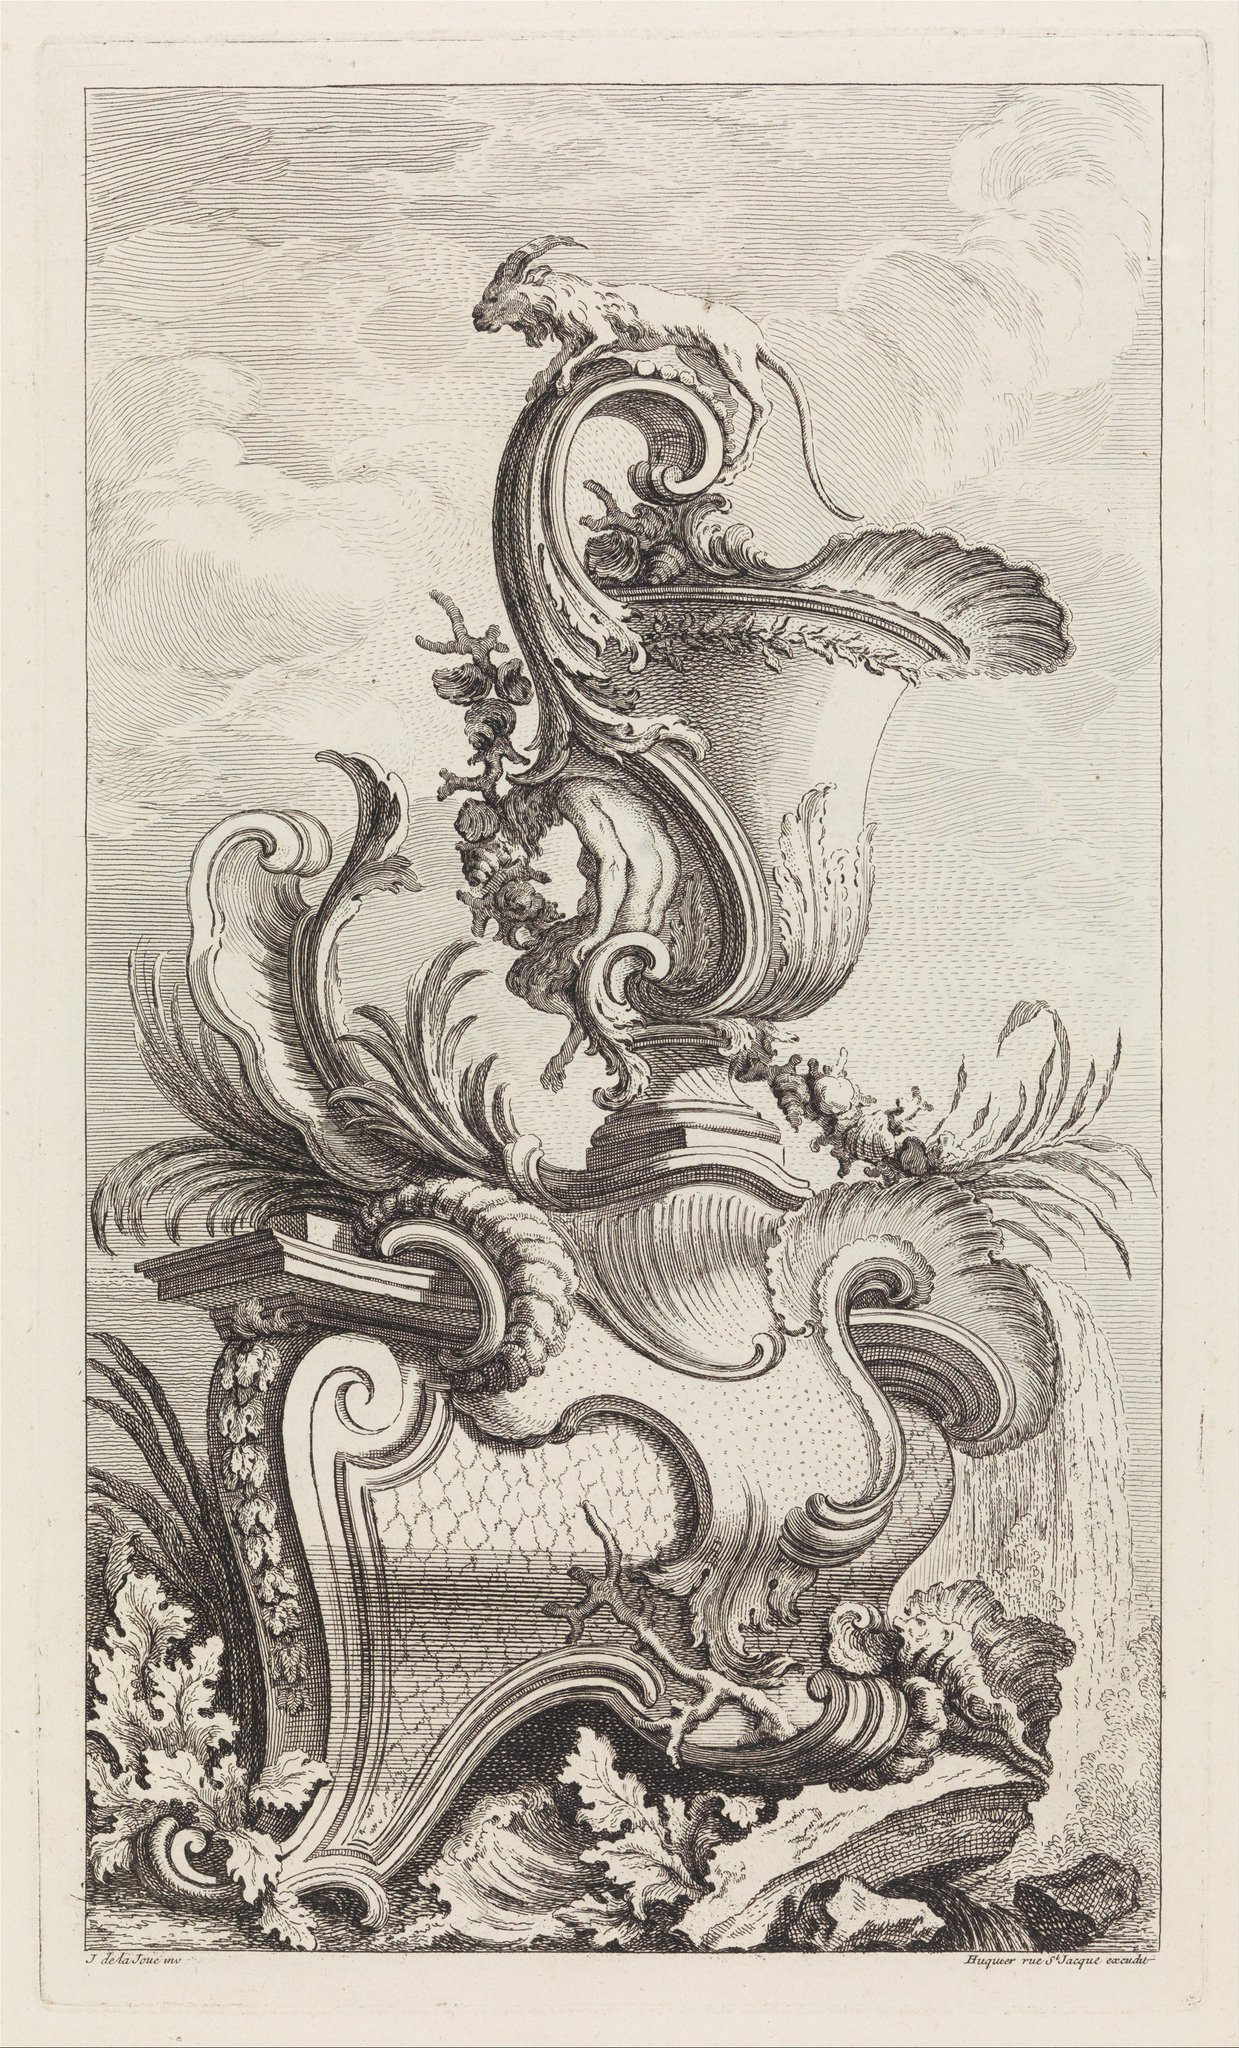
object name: book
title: Plate from Book of Vases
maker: jacques de la joue the younger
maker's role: artist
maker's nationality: french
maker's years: 1686-1761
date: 1701-1800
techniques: etching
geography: france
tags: vases